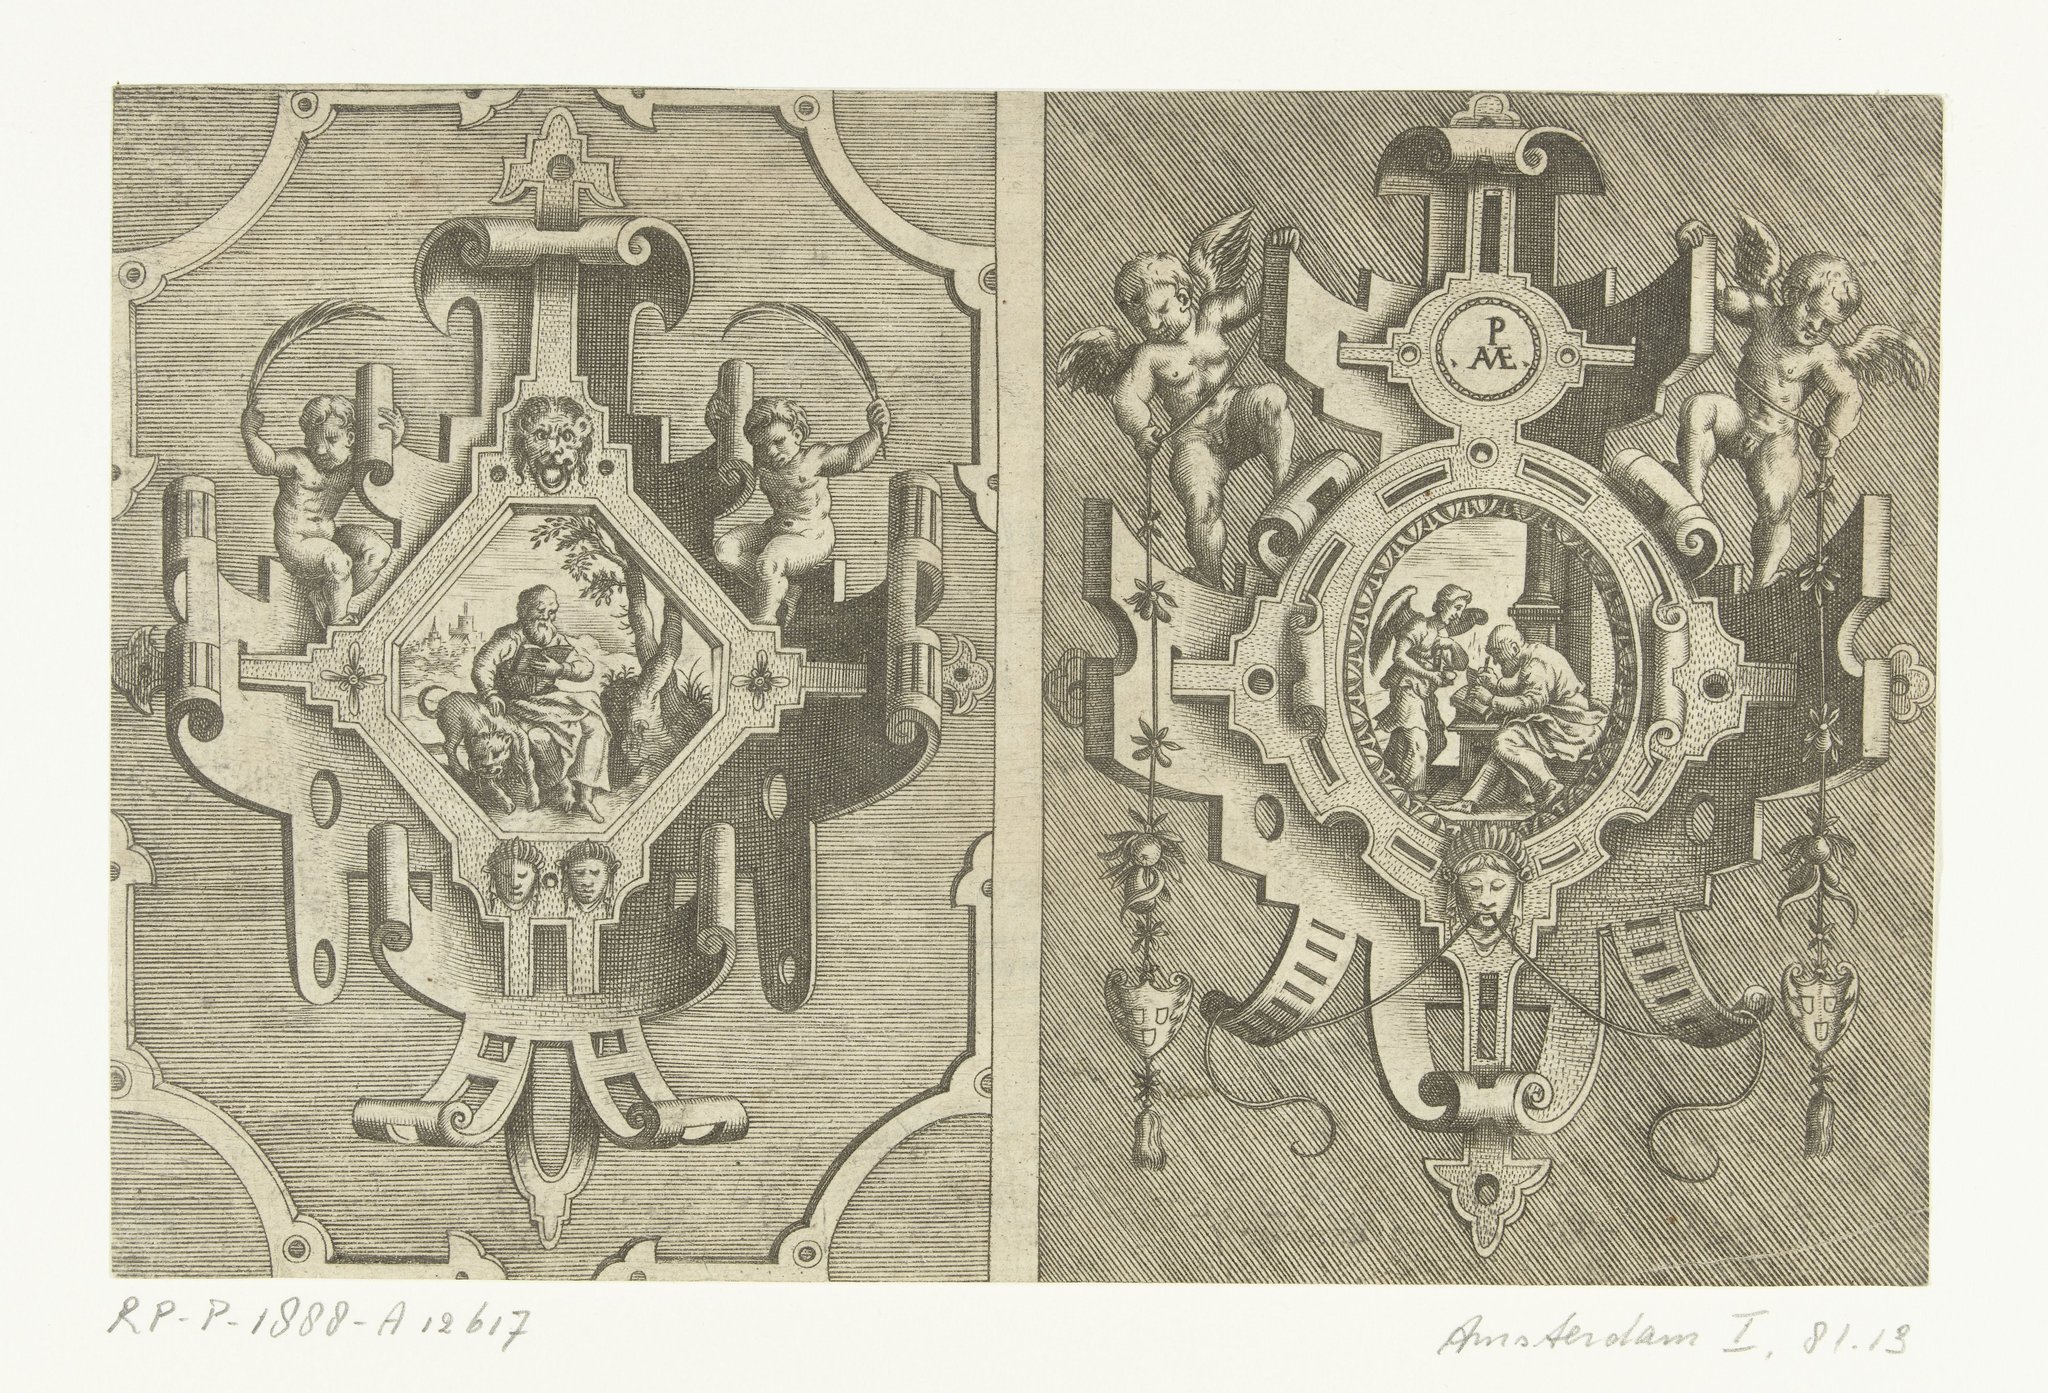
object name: ornament print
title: Compertimentorum quod vocant multiplex genus…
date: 1566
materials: paper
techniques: engraving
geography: netherlands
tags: the apostle and evangelist matthew (mattheus); possible attributes: angel, axe, book, halberd, pen and inkhorn, purse, scroll, square, sword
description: Twee cartouches op één blad. Links Lucas en rechts Johannes. Gearceerde achtergrond. Blad uit serie bestaande uit een titelblad en 15 van de 16 bladen met cartouches met bijbelse en mythologische voorstellingen in een omlijsting van rolwerk en grotesken.